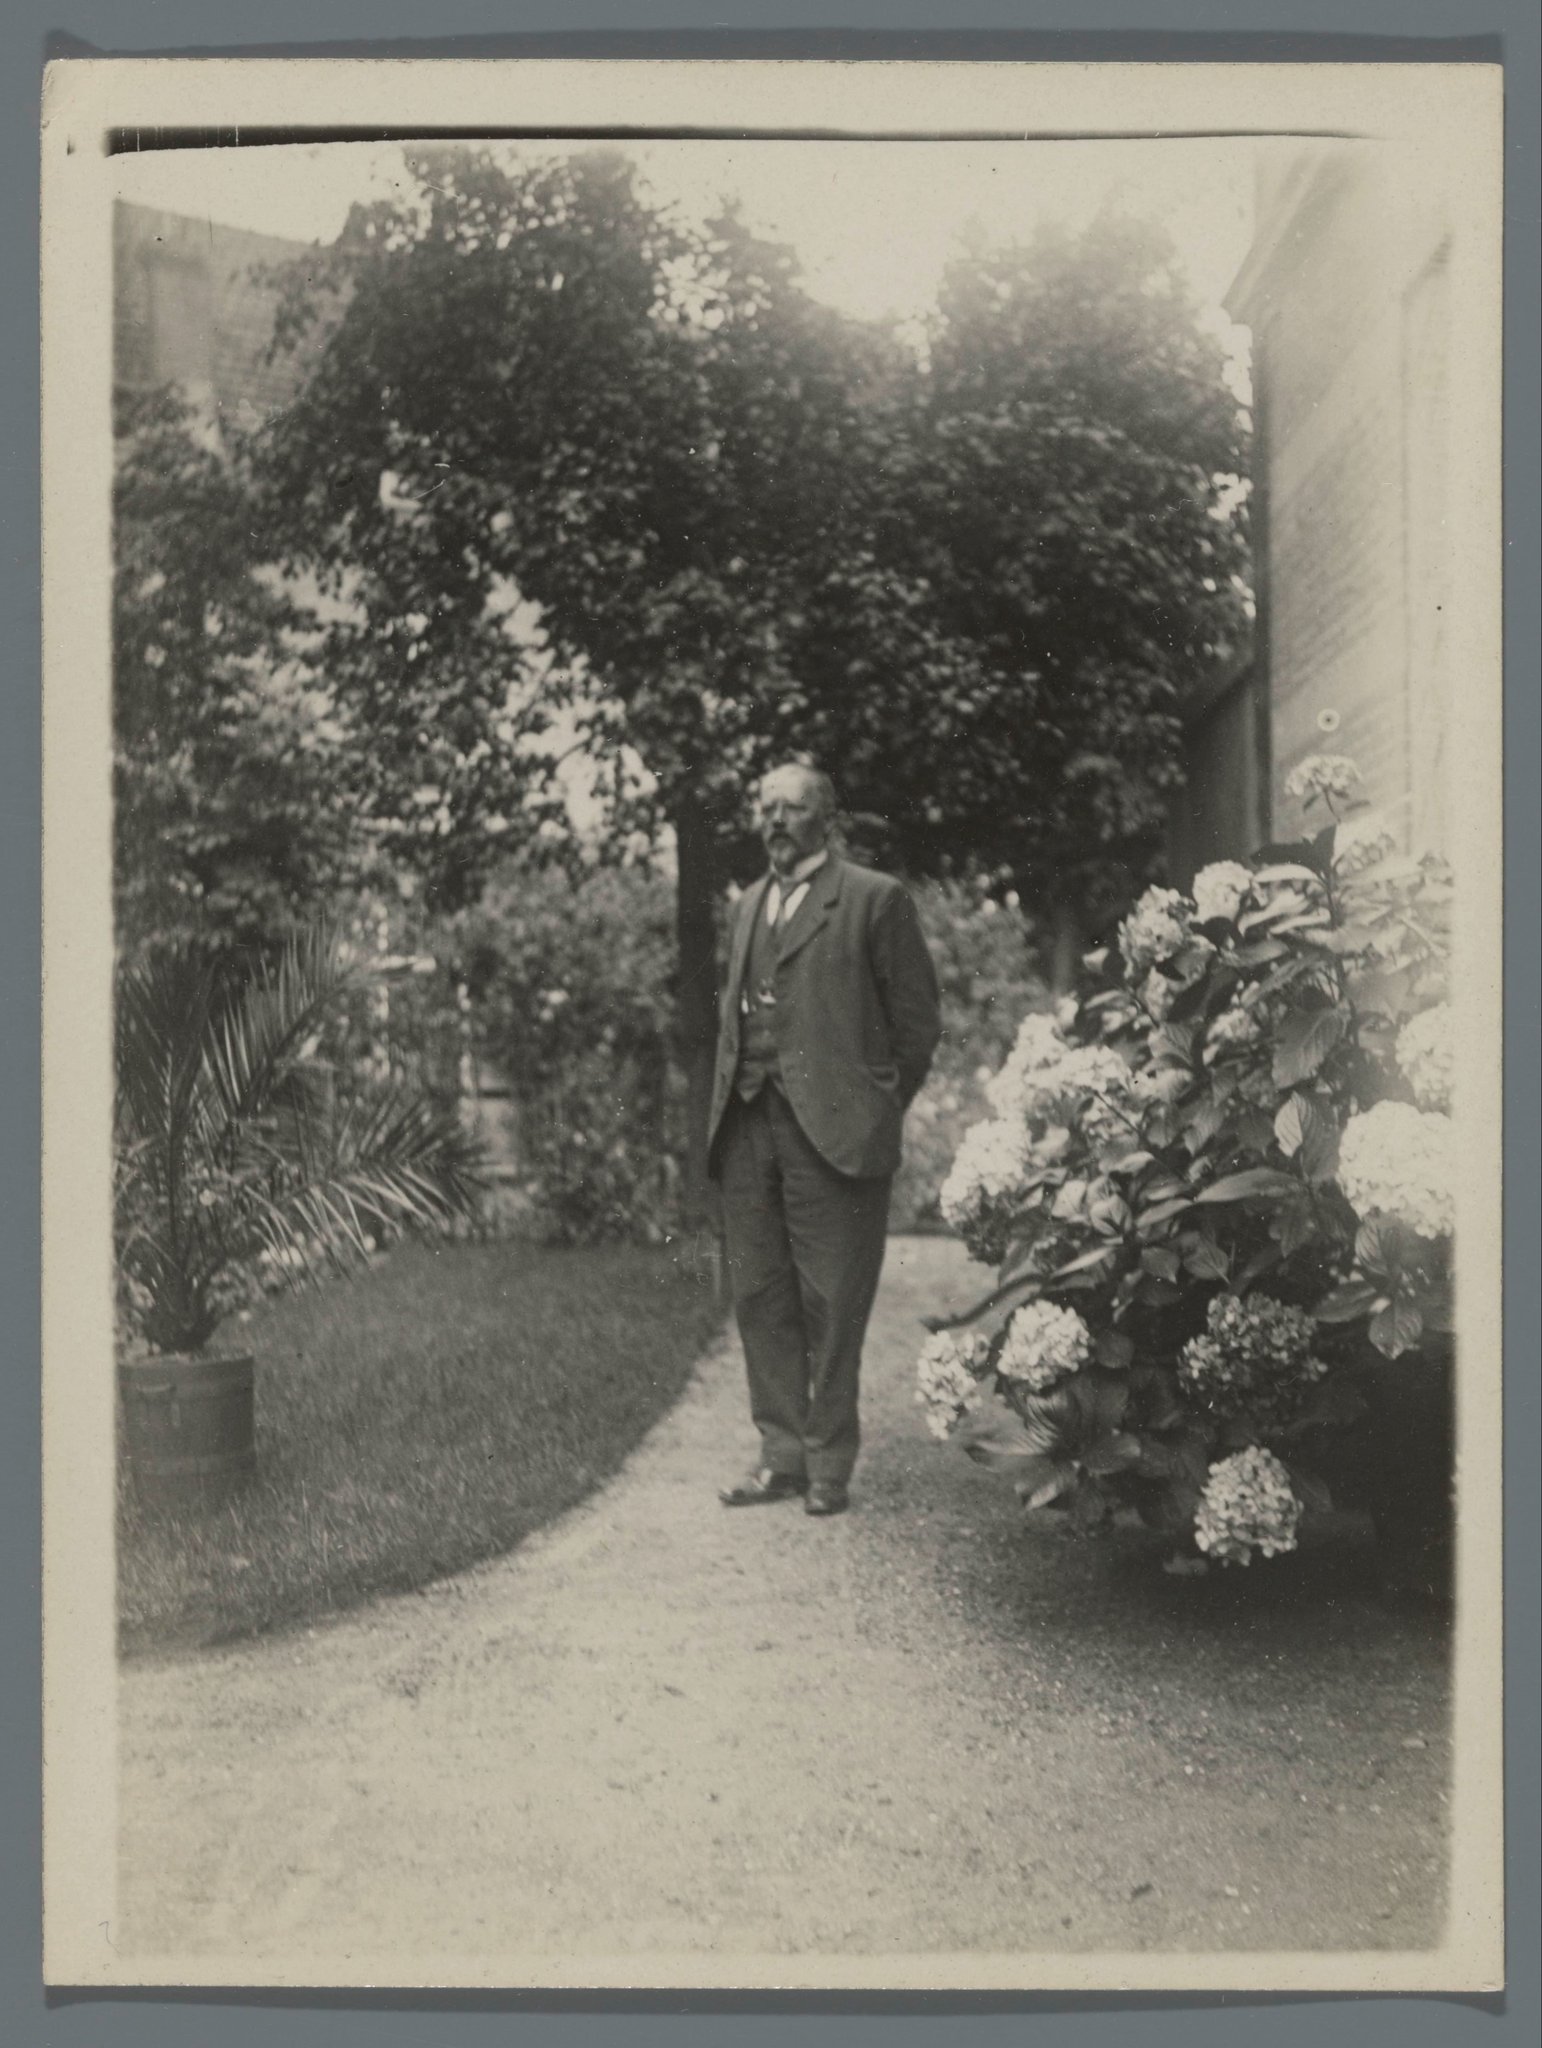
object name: photograph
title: Portret van Lucas Jonker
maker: cornelia hendrika jonker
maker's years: 1874-1924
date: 1910-1950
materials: photographic support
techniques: gelatin silver print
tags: garden, historical persons